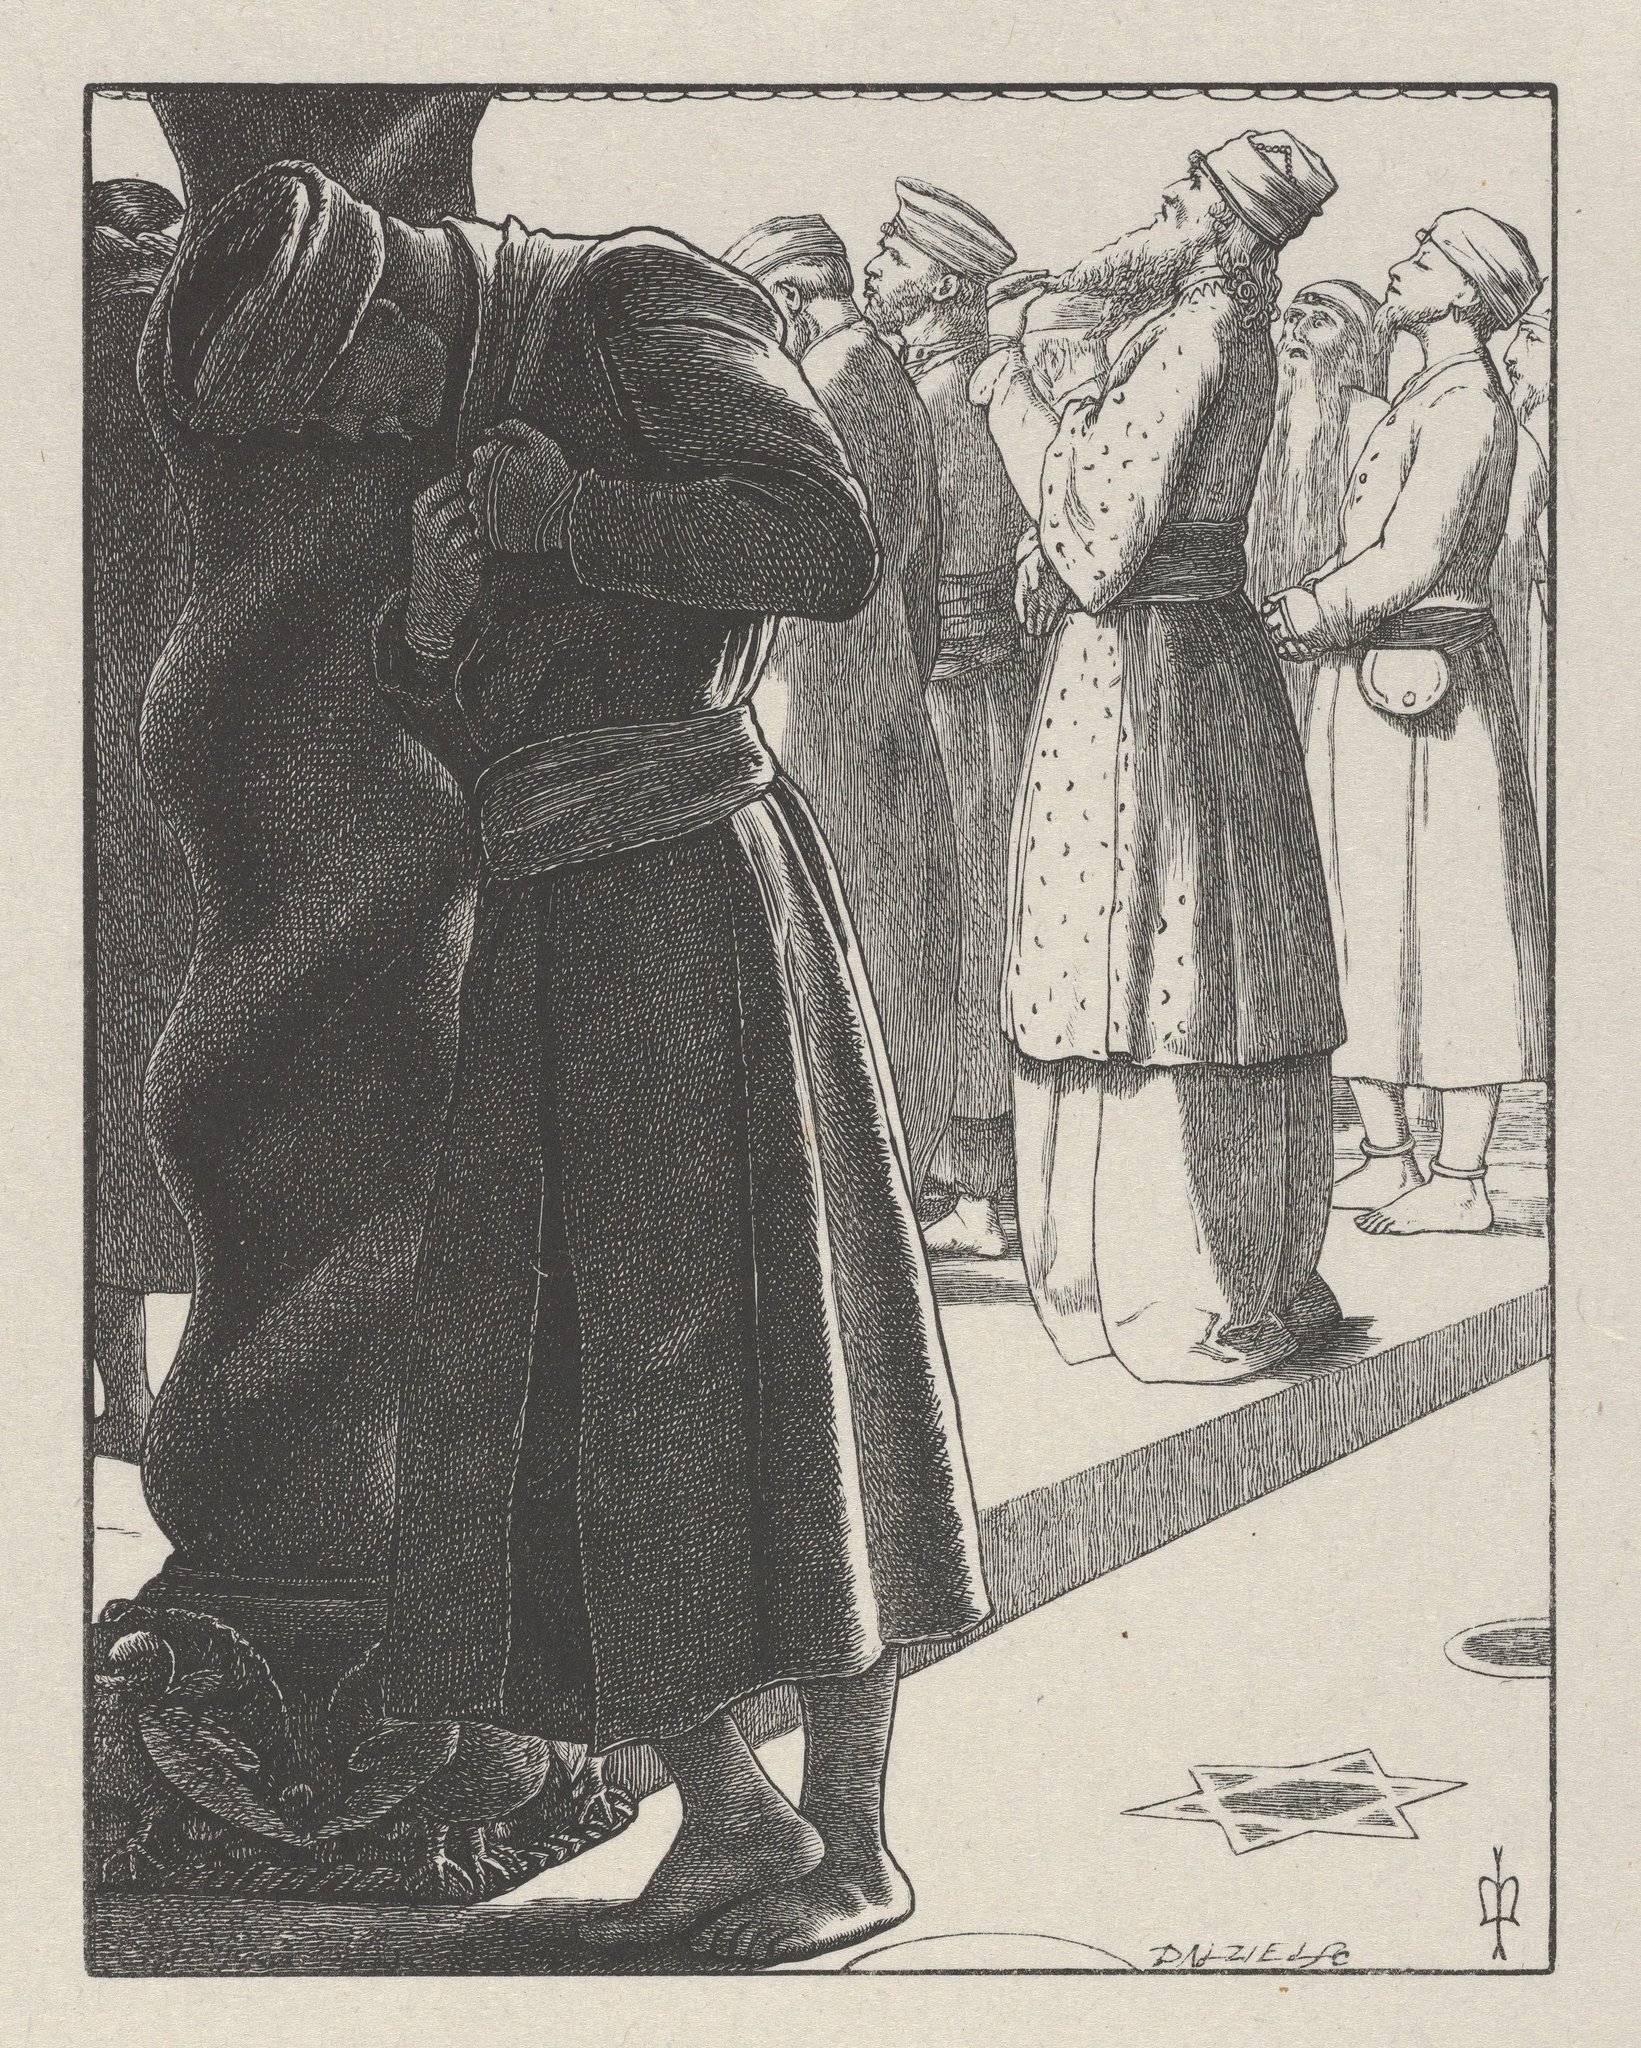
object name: print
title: The Pharisee and the Publican (The Parables of Our Lord and Saviour Jesus Christ)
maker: sir john everett millais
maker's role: artist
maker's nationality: british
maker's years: 1829-1896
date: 1864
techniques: engraving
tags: men